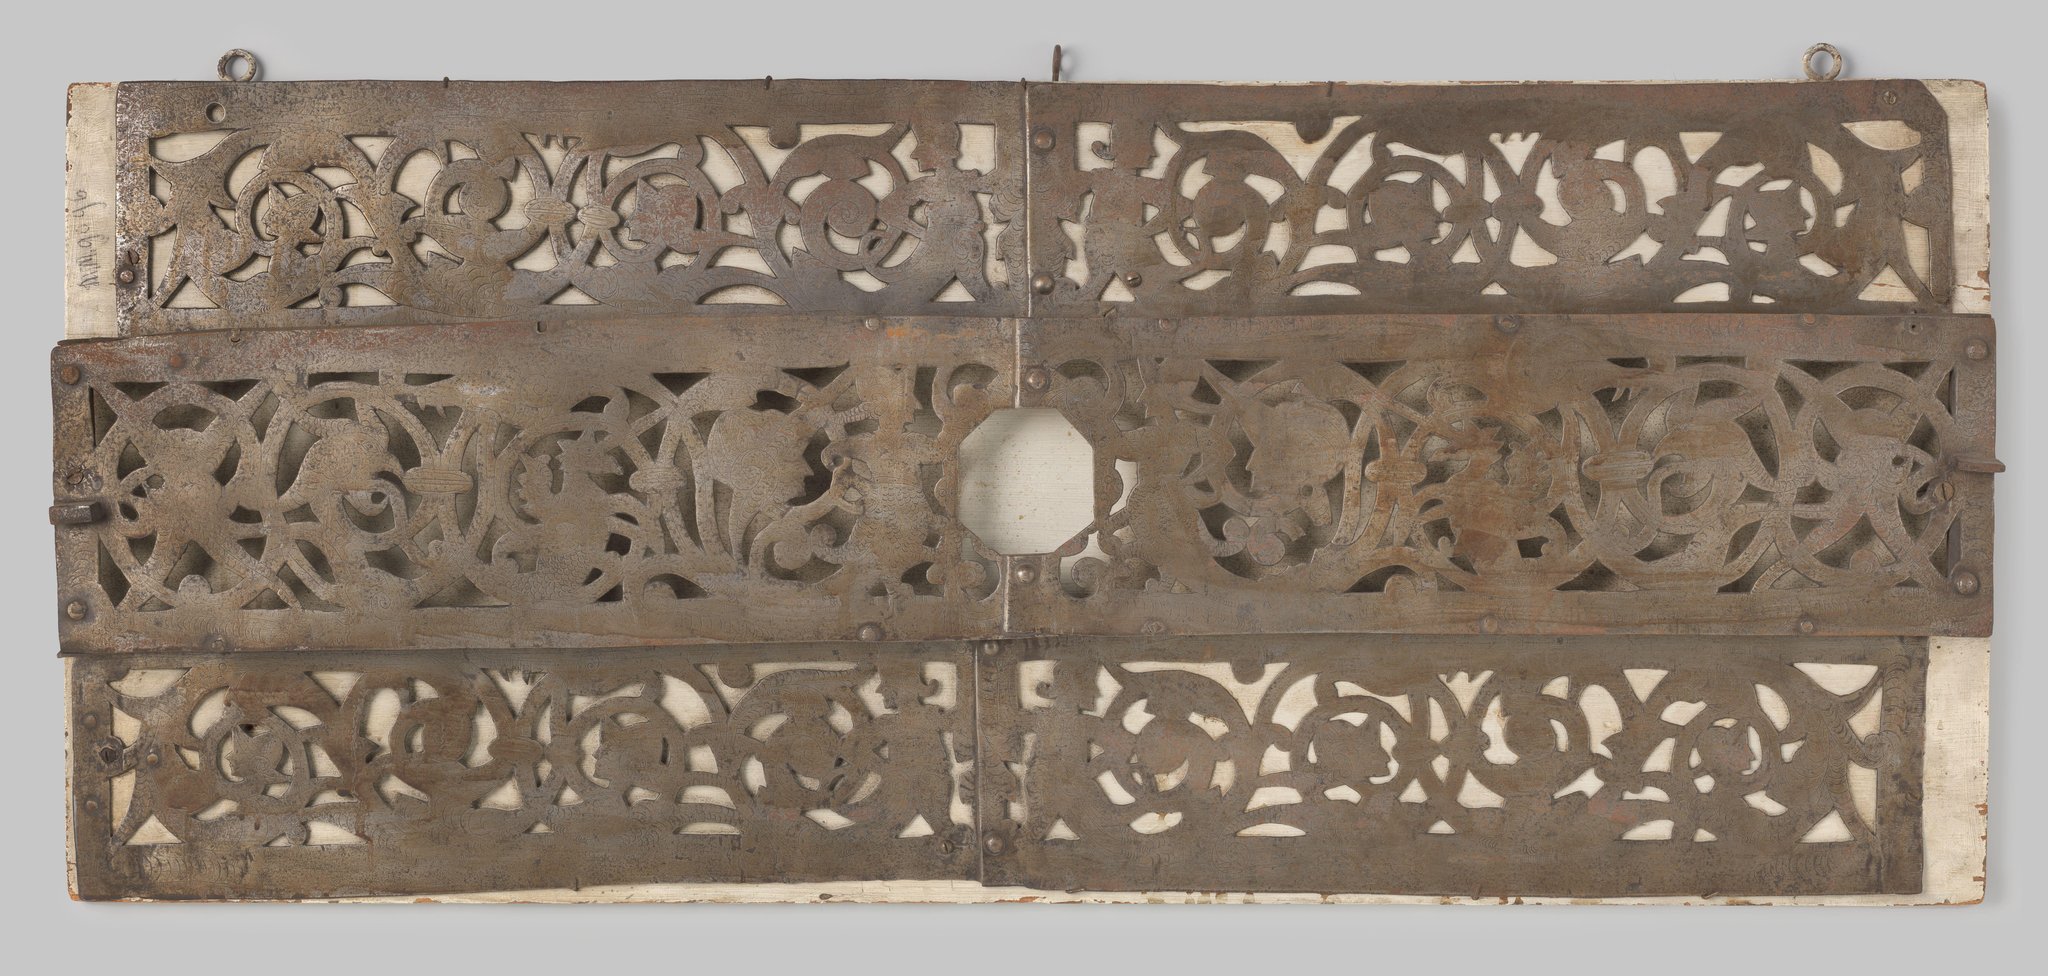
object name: beslag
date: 1400-1950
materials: iron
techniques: forging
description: Beslag van het binnengedeelte van een koffer. Met uitgeslagen beelden en ornamenten. Gemerkt.